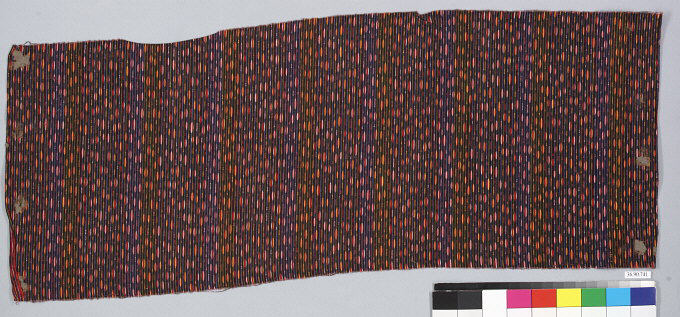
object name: piece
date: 1867-1900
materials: cotton